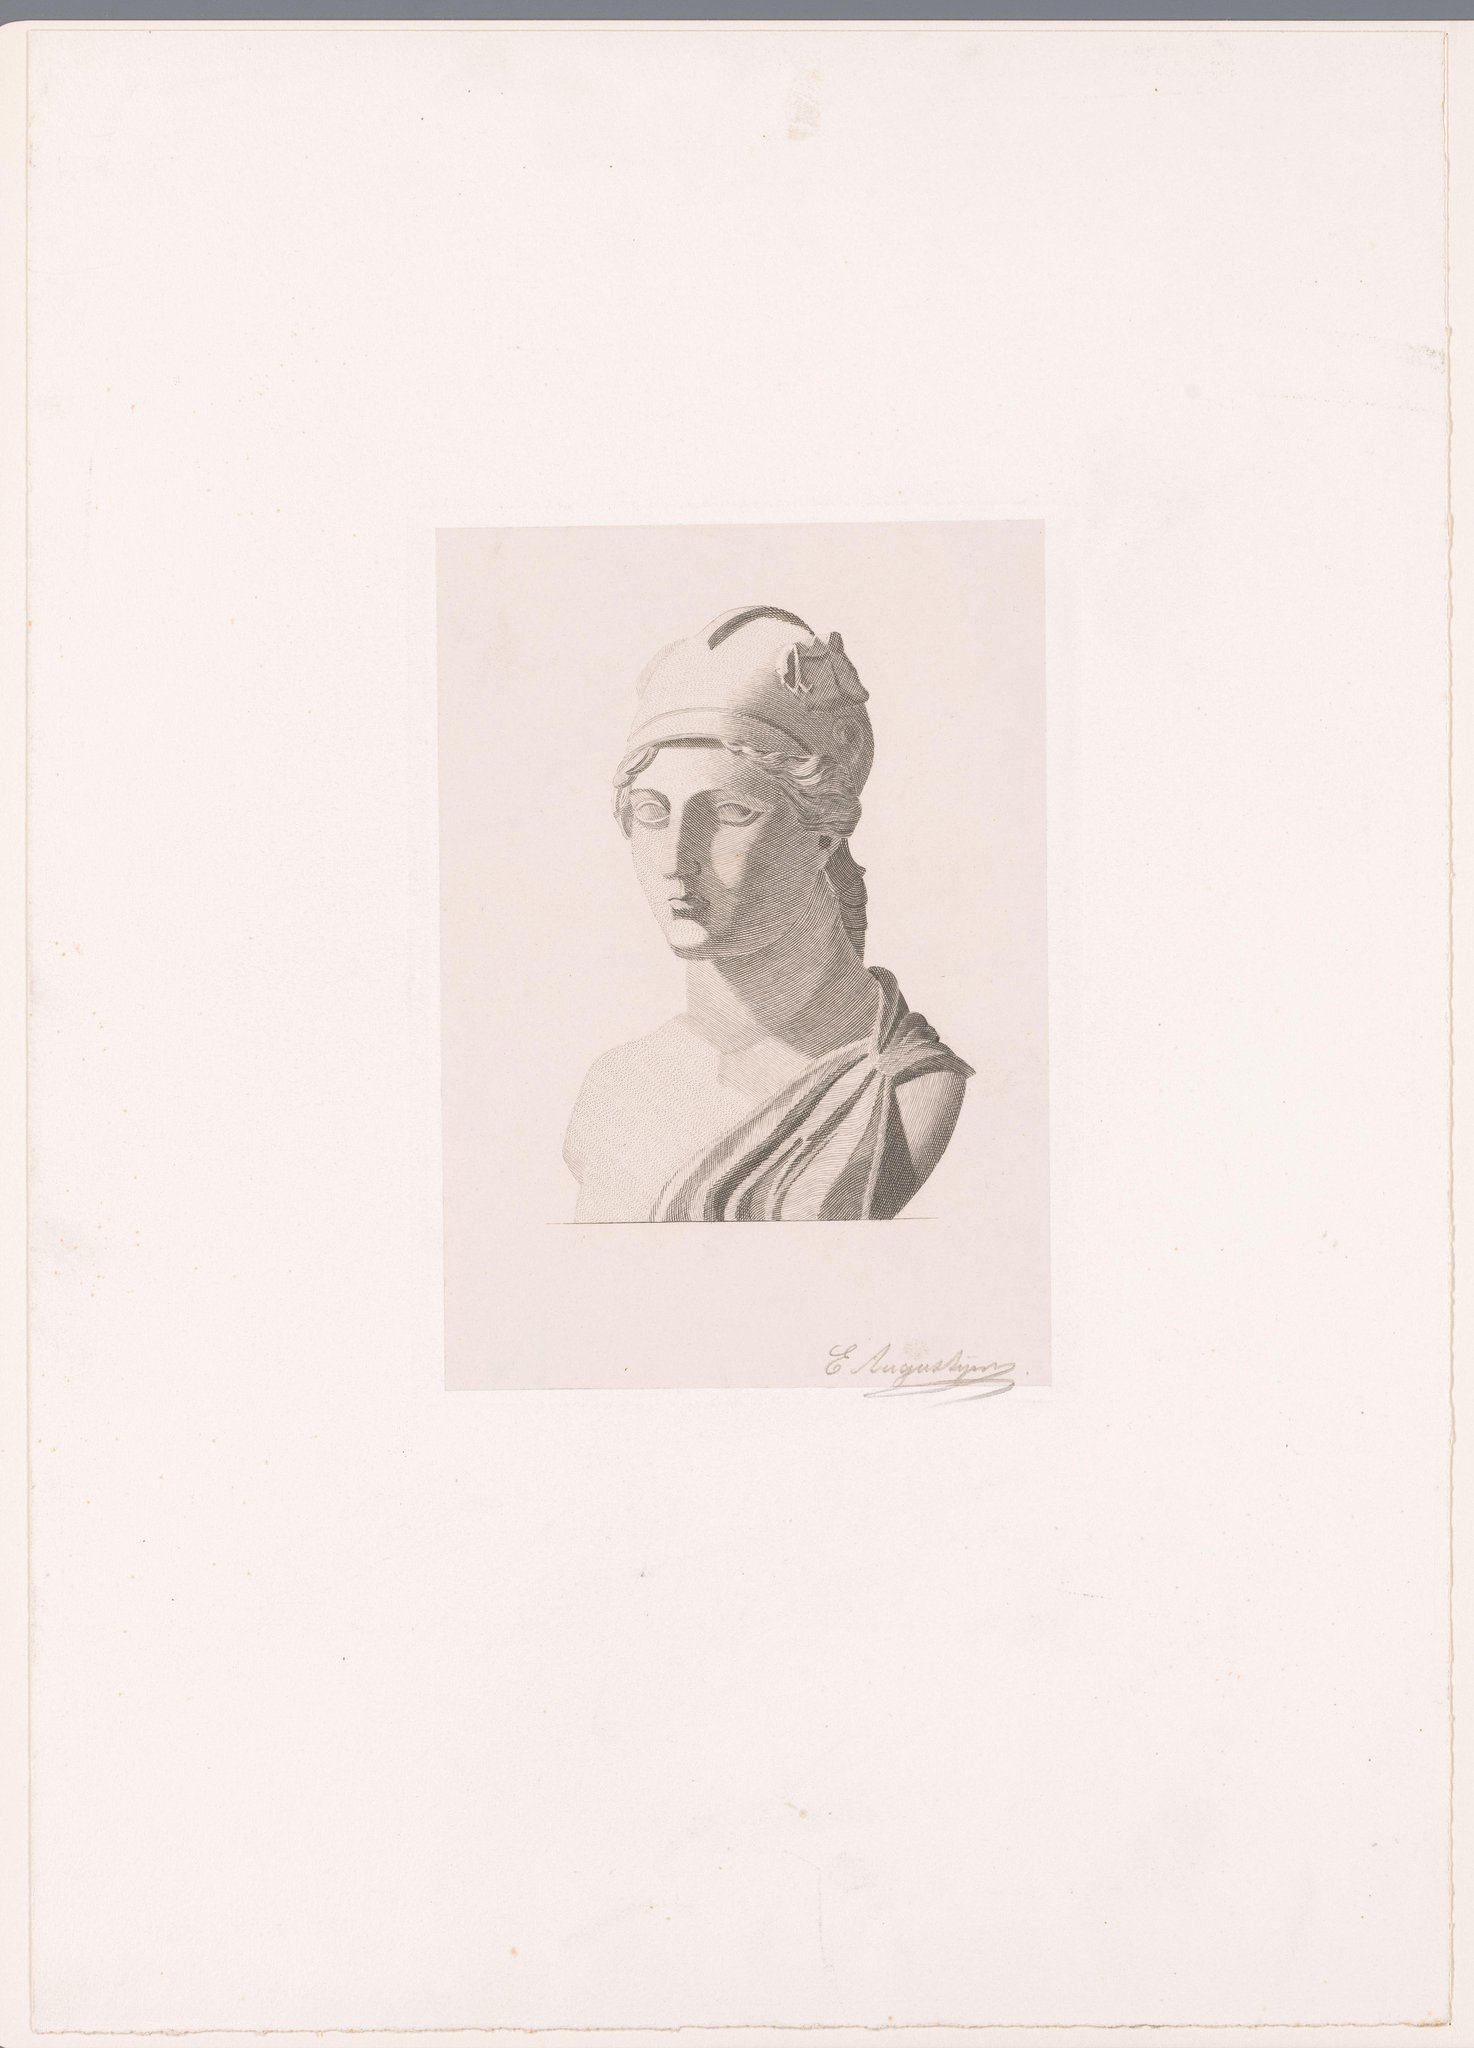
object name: print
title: Buste van Minerva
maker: eduard augustyns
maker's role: print maker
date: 1850-1909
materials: paper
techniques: etching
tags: (story of) minerva (pallas, athena)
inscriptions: collector's mark: Lugt 2228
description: Sterfdatum kunstenaar onbekend. Derhalve is voor bepaling van de rechten van dit object de verwervingsdatum aangehouden.